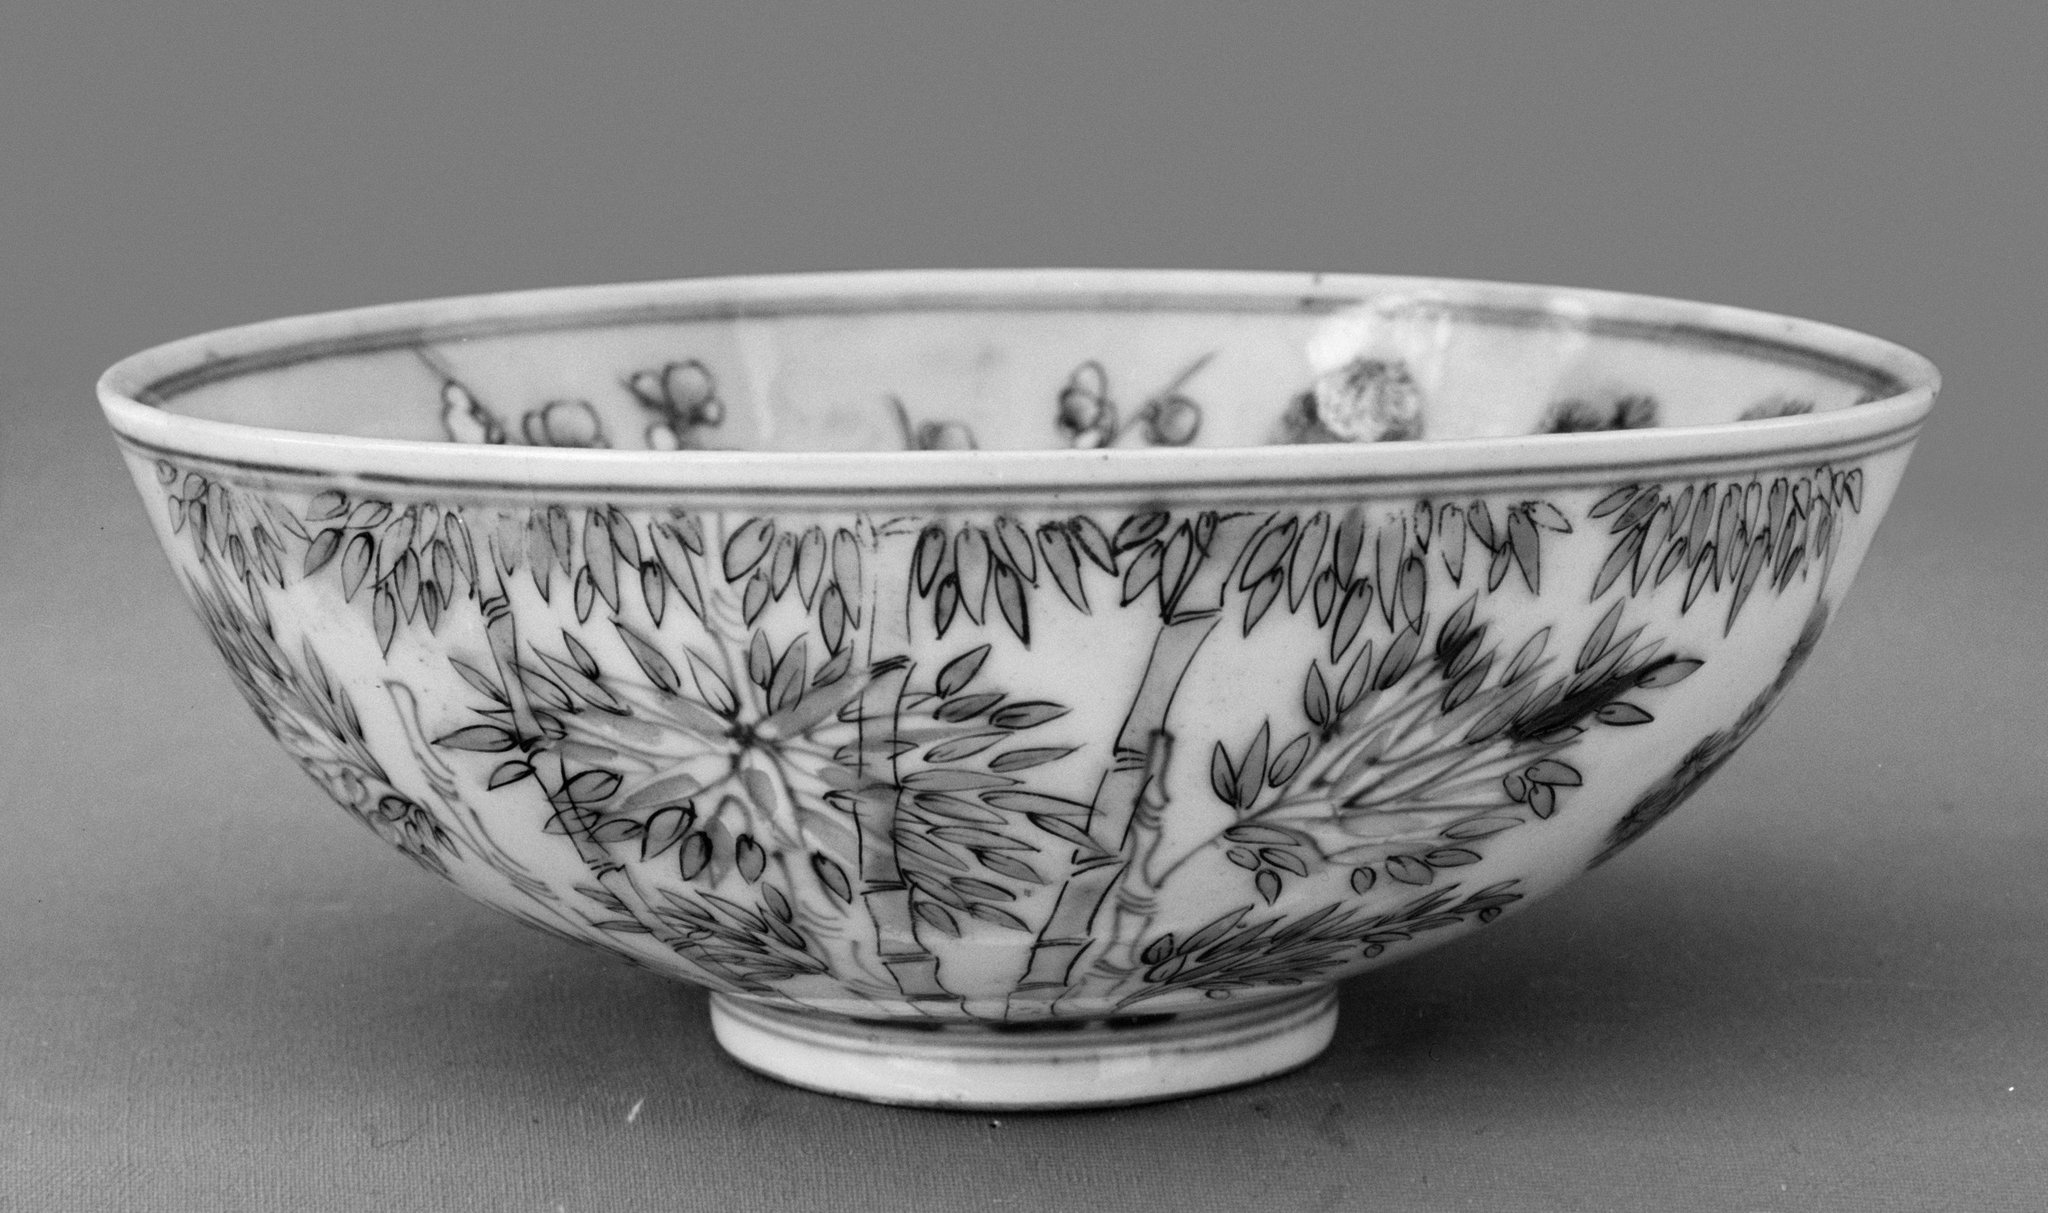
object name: bowl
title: Bowl with pine tree, bamboo, and plum blossom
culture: chinese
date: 1767-1800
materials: cobalt, enamel, porcelain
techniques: overglaze, painting, polychrome, underglaze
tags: bamboo